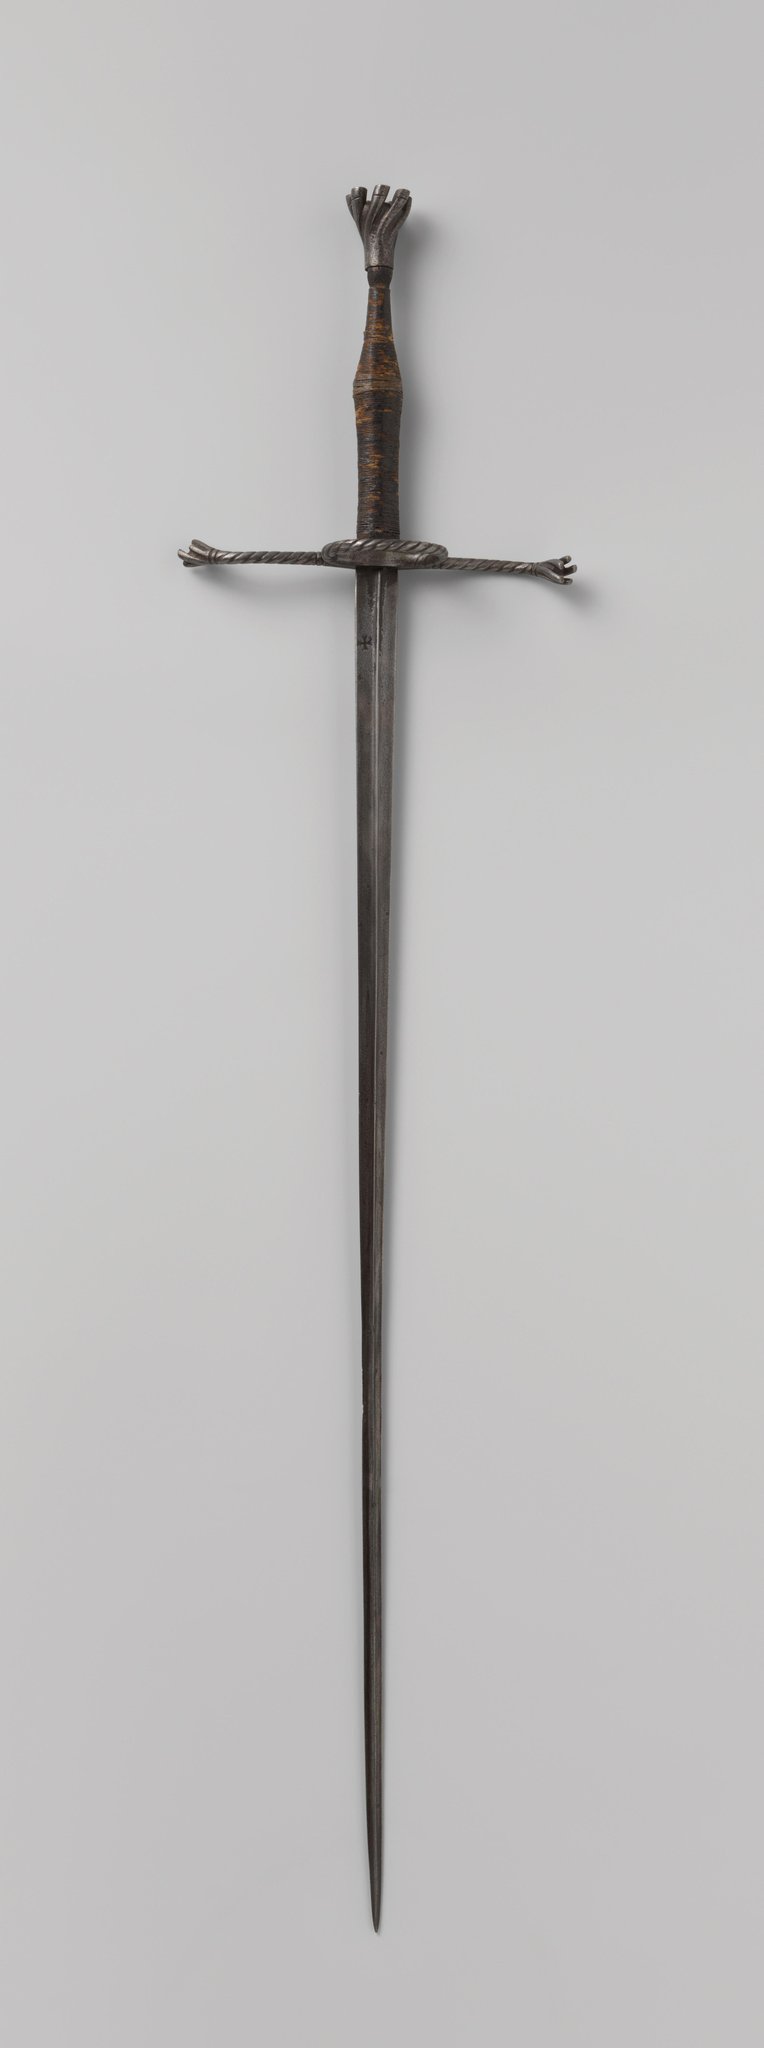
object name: sword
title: IJzeren zwaard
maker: Anonymous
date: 1500-1550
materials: iron, fiber, wood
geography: europe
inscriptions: mark: ‘maltezer kruis’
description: IJzeren zwaard, tweesnijdend, de kling over de volle lengte aan weerskanten voorzien van een richel, waarnaast aan één zijde bovenaan een klein Grieks kruis. De greep, die eindigt in een zeven... versierde afgeplatte knop, is omwoeld met zwart gemaakt touw. De pareerstang is getorst, eindigt in vijfdelige afgeplatte knoppen en is flauw s-vormig gebogen. Eén zijde heeft een ovaal lopende band bij wijze van stootplaat.